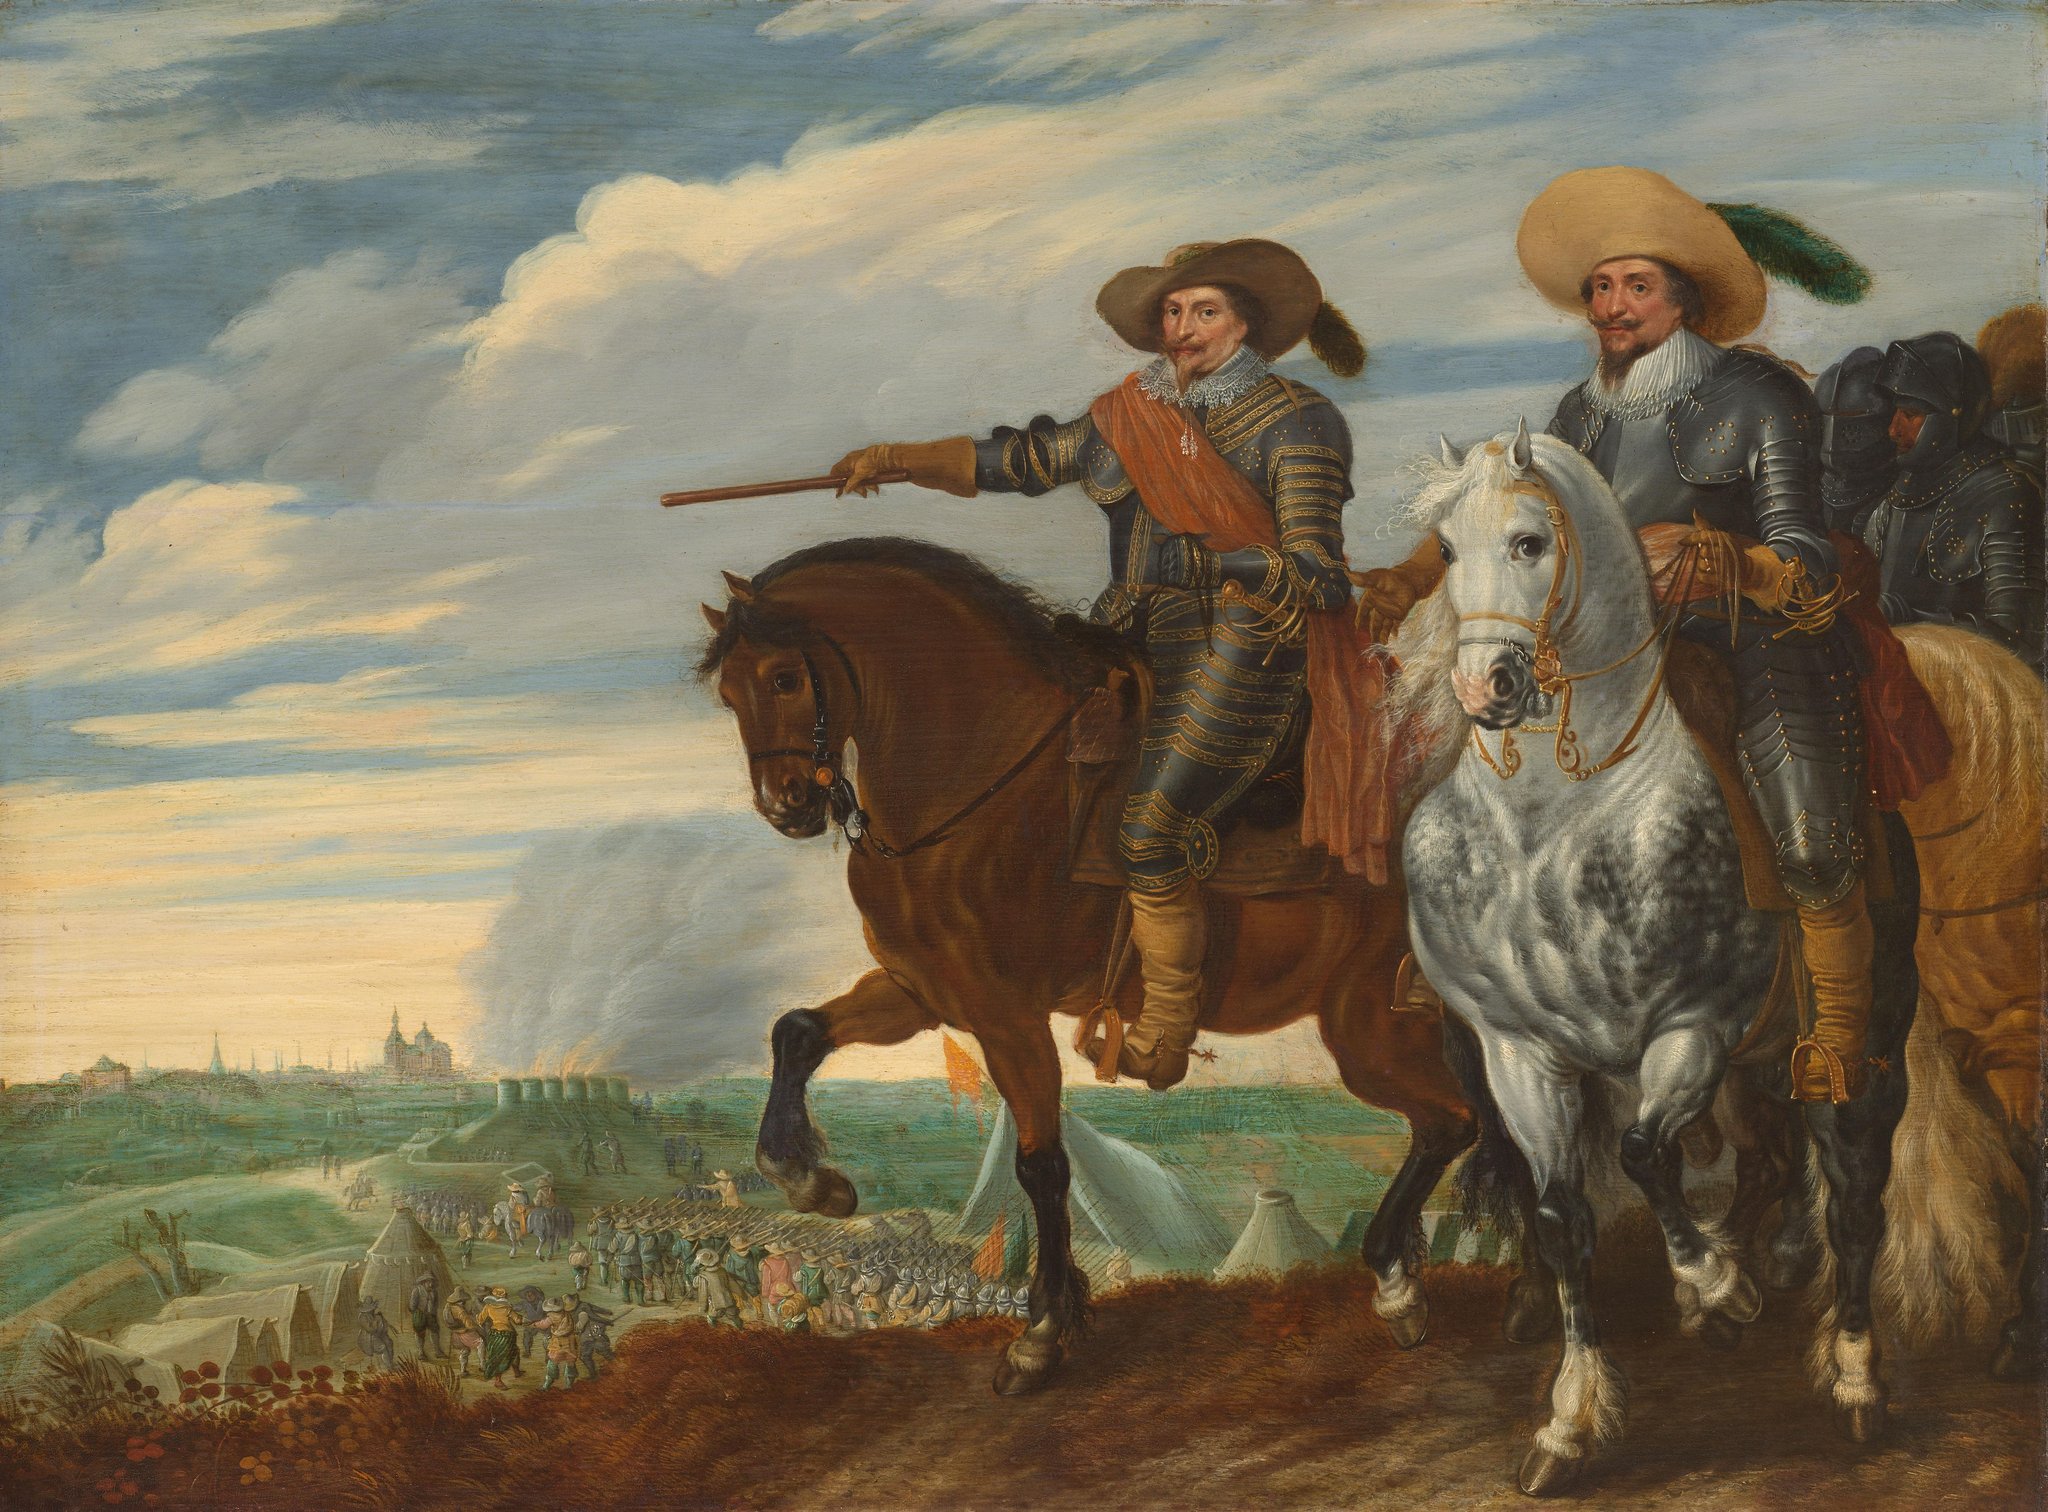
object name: painting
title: Frederick Henry and Ernst Casimir of Nassau-Dietz at the Siege of ’s Hertogenbosch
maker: pauwels van hillegaert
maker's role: painter, print maker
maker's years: 1596-1658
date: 1629-1635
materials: oil, panel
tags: the hague, frederick henry (prince of orange), ernst casimir graaf van nassau-dietz, riding a horse, ass, or mule; rider, horseman, siege, baton of general, den bosch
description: Prince Frederick Henry and his cousin Count Ernst Casimir pose triumphantly on their horses before ’s-Hertogenbosch. Frederick Henry points his commander’s staff at the Habsburg-occupied city now being stormed by Dutch forces. It was not for nothing that he was nicknamed ‘the conqueror of cities’. He captured a series of cites from the Spanish. The retaking of ‘s-Hertogenbosch in 1629 was one of the most important.